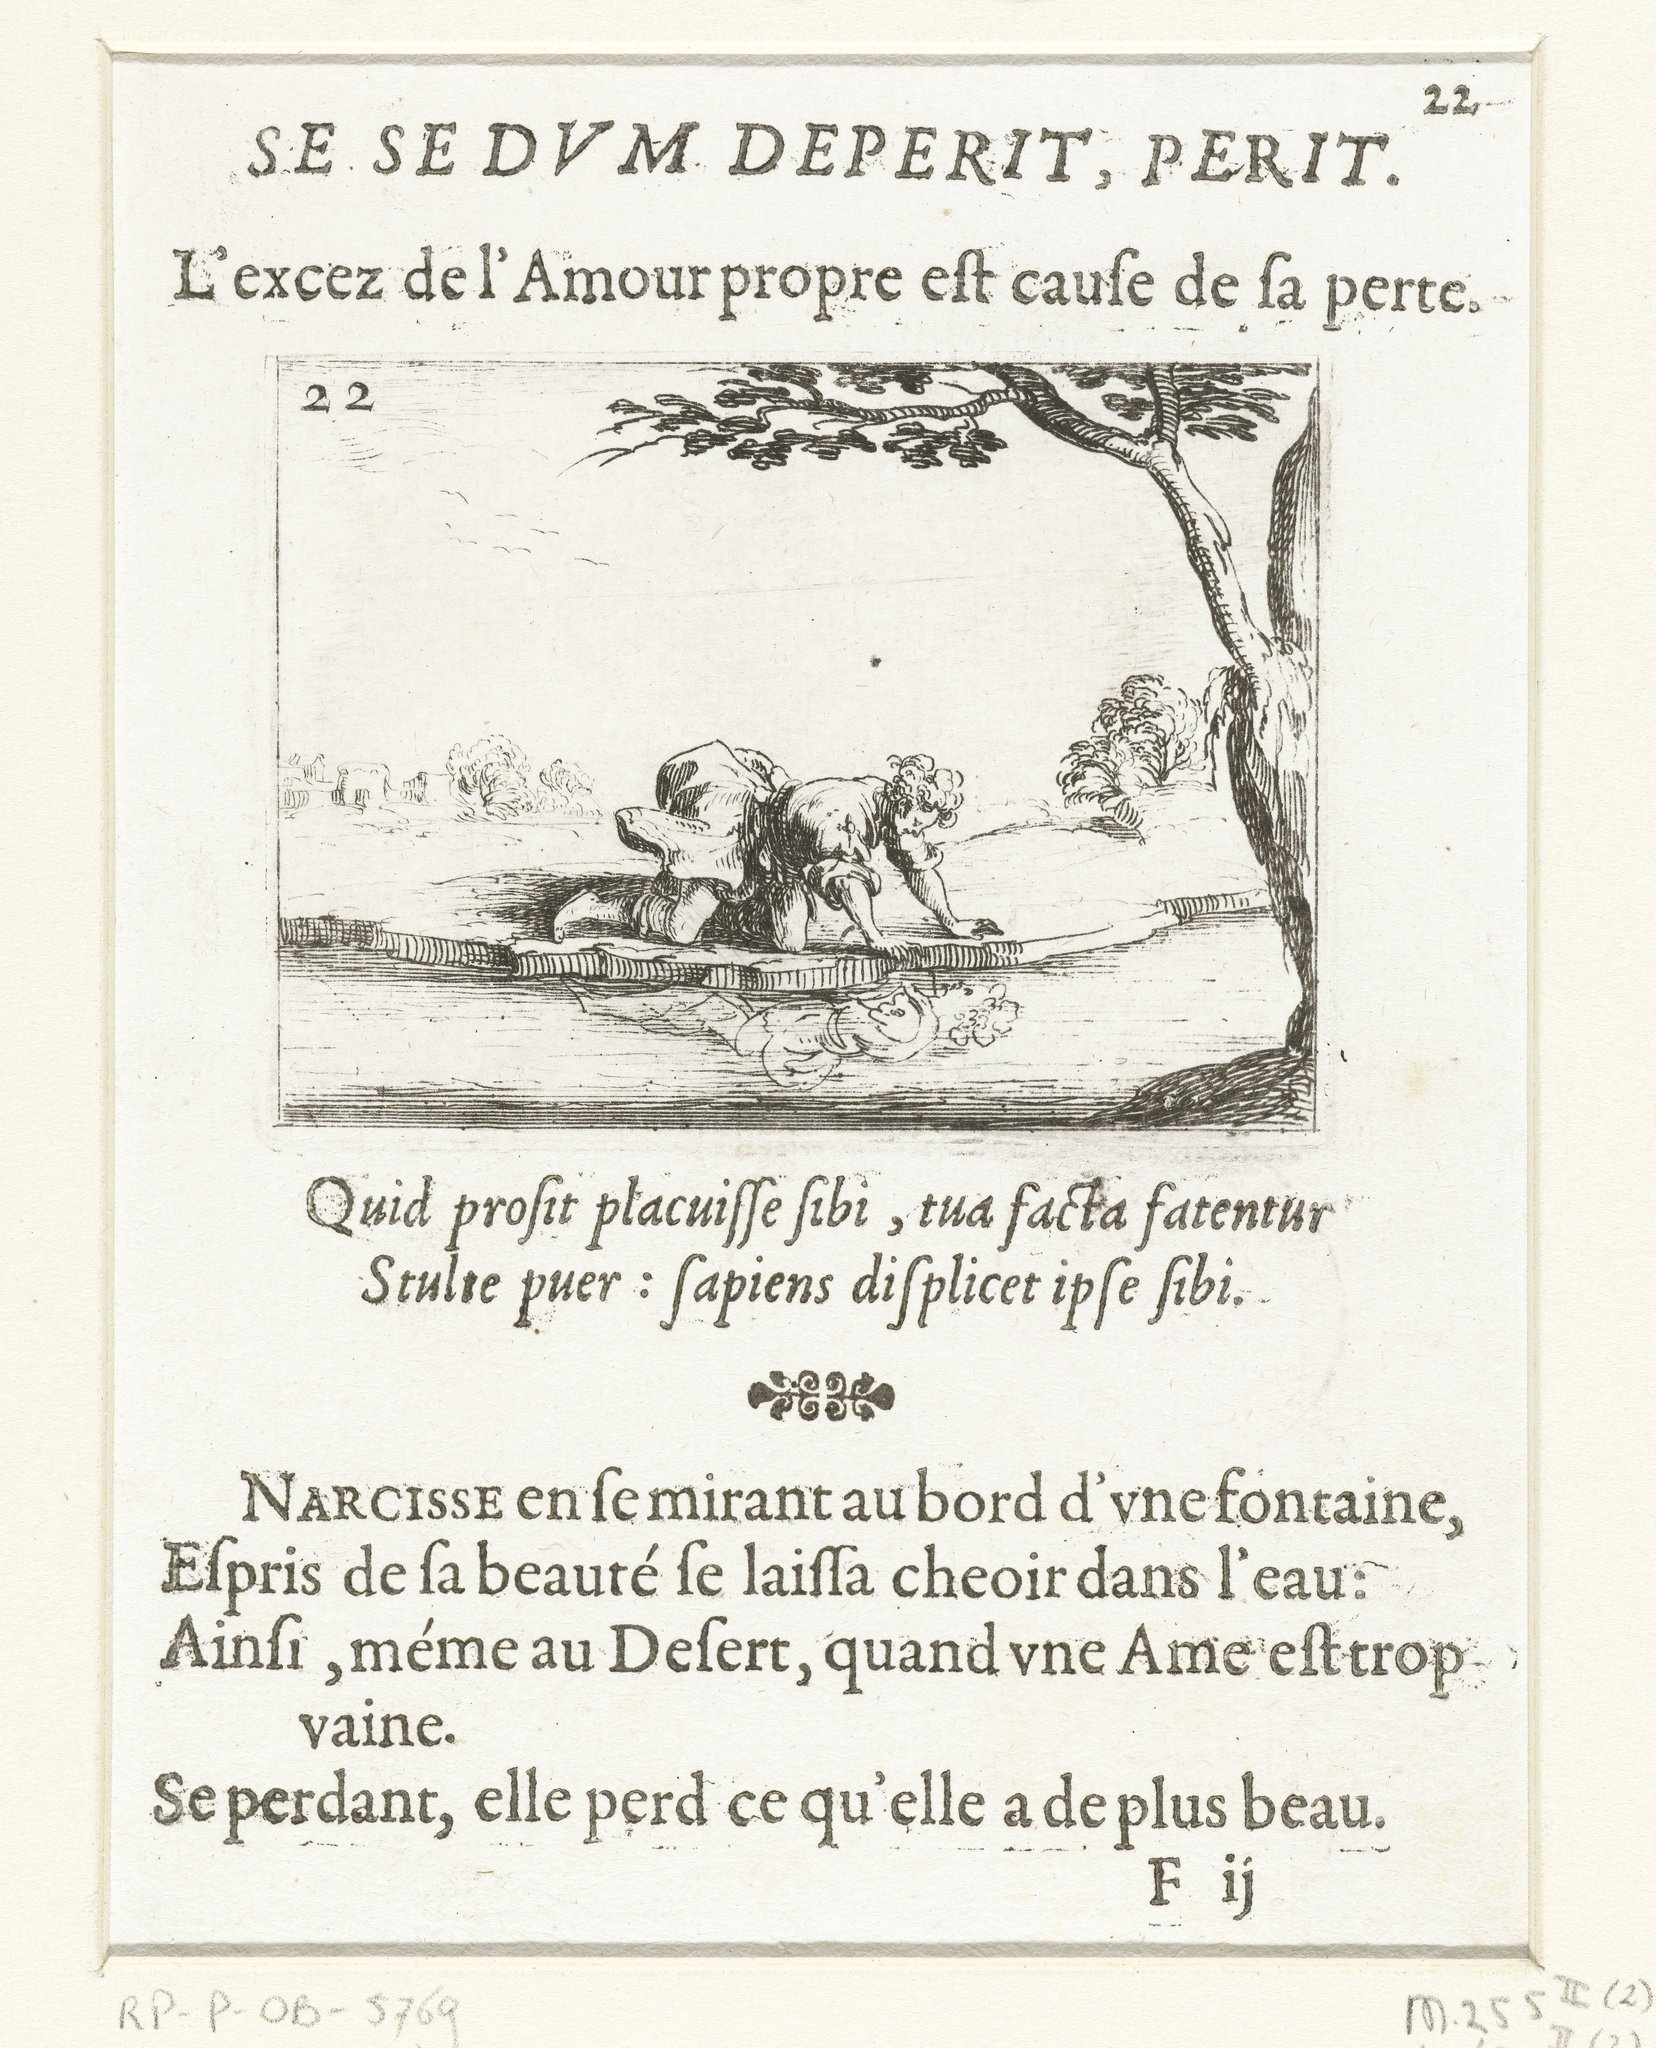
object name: cognizance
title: Narcissus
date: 1621-1635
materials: paper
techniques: etching, letterpress printing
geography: nancy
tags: narcissus, gazing in a fountain, falls in love with his own reflection; possibly the nymph echo peeps at the scene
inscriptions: collector's mark: Lugt 240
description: The loosely etched Narcissus kneels in a spare, deserted landscape. The text cautions against excessive love, which would only bring bad fortune. The print is part of a series of emblems devoted to monastic life. In a total of 27 prints, the reader is advised to live chastely, obediently, and humbly; only then is heaven within reach.